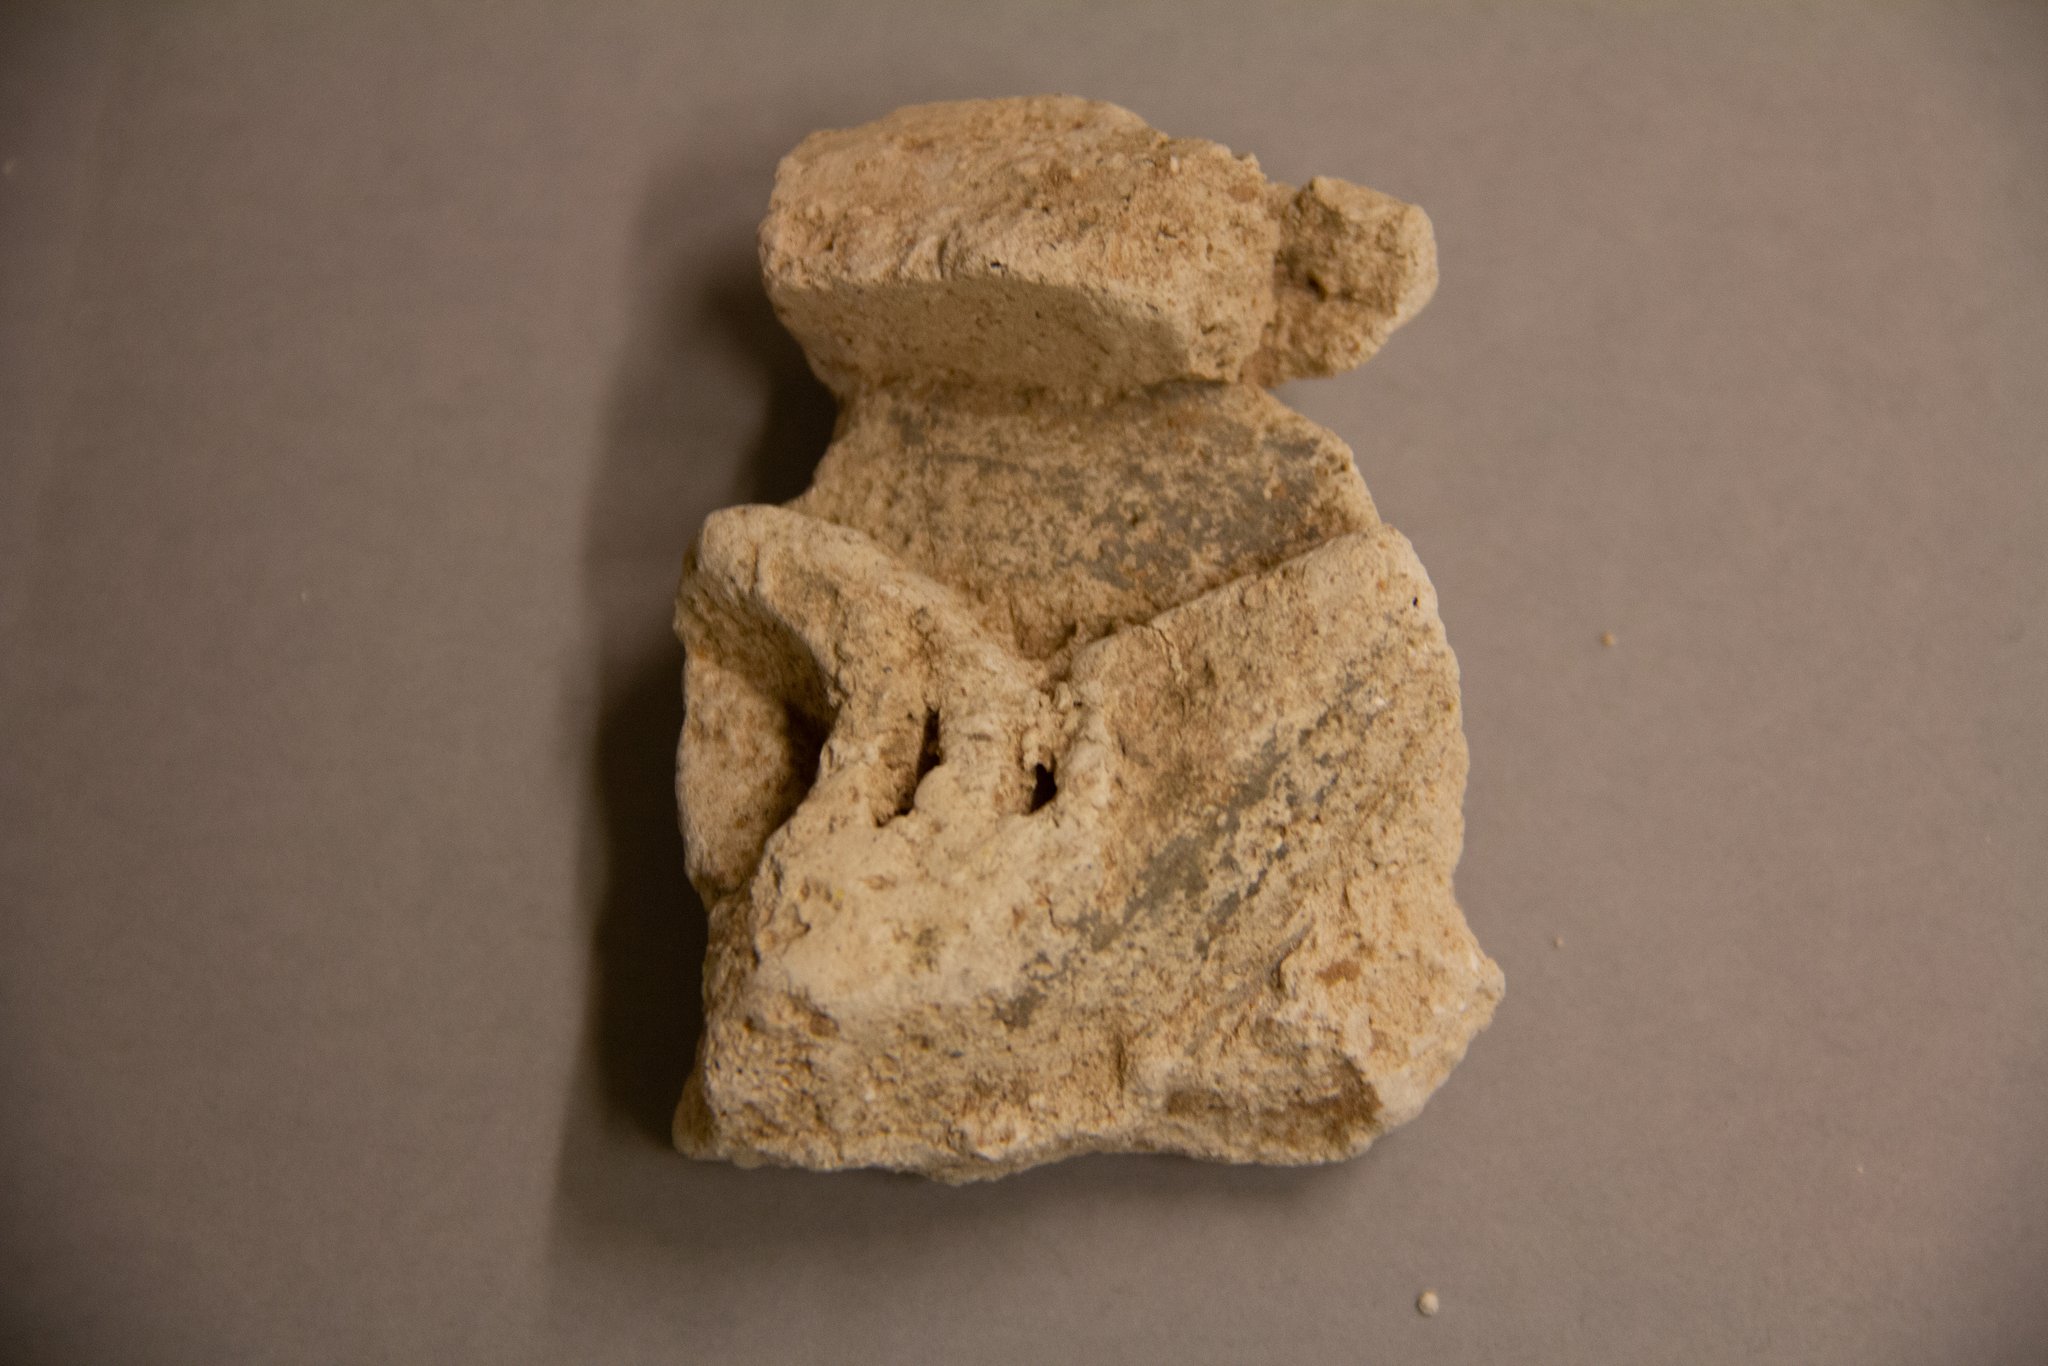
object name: fragment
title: Stucco Fragment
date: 701-1200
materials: plaster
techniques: carving, painting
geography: iran